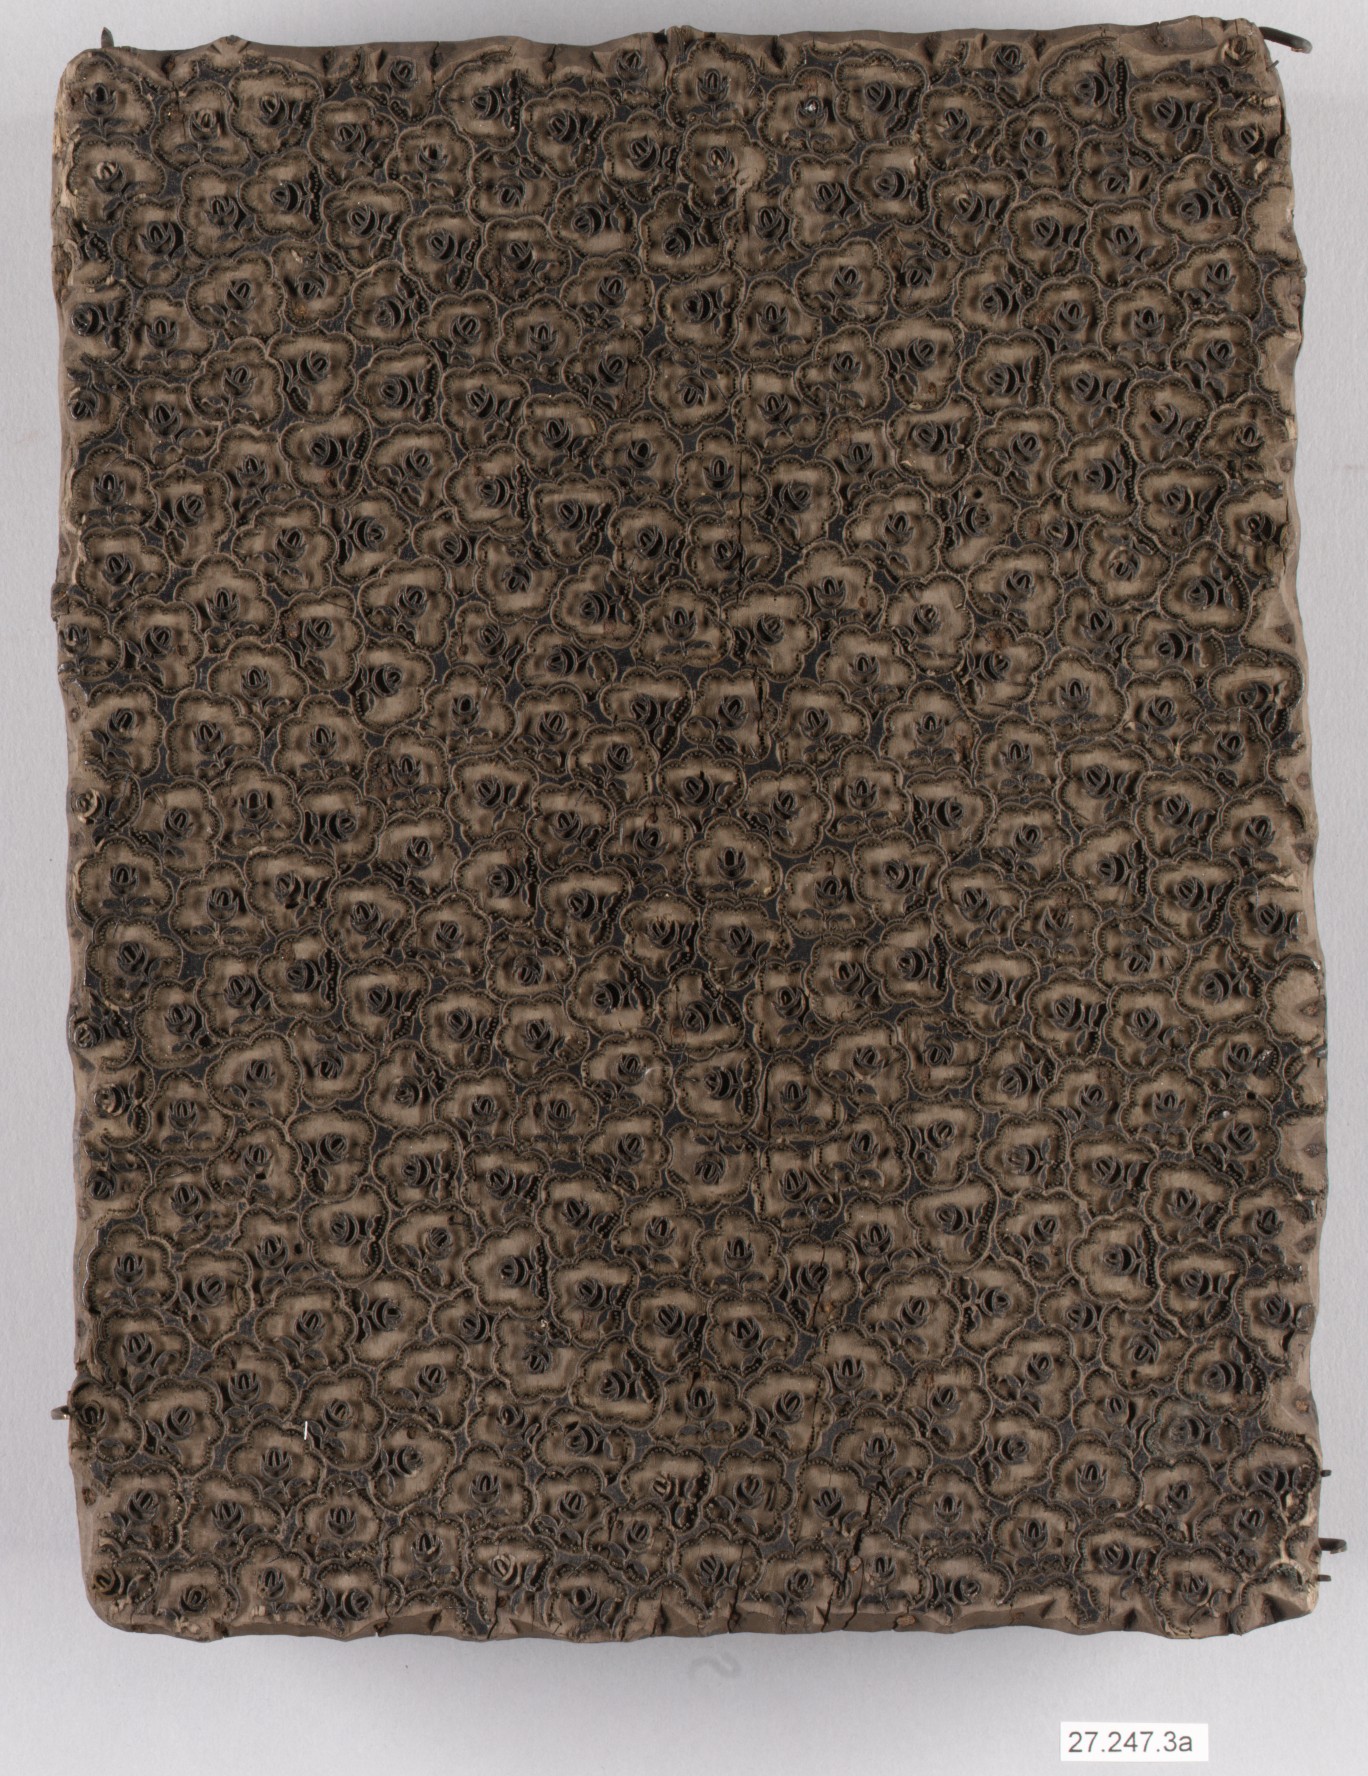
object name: woodblock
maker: swaislands fabric printing works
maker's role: designer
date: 1767-1800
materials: metal, wood